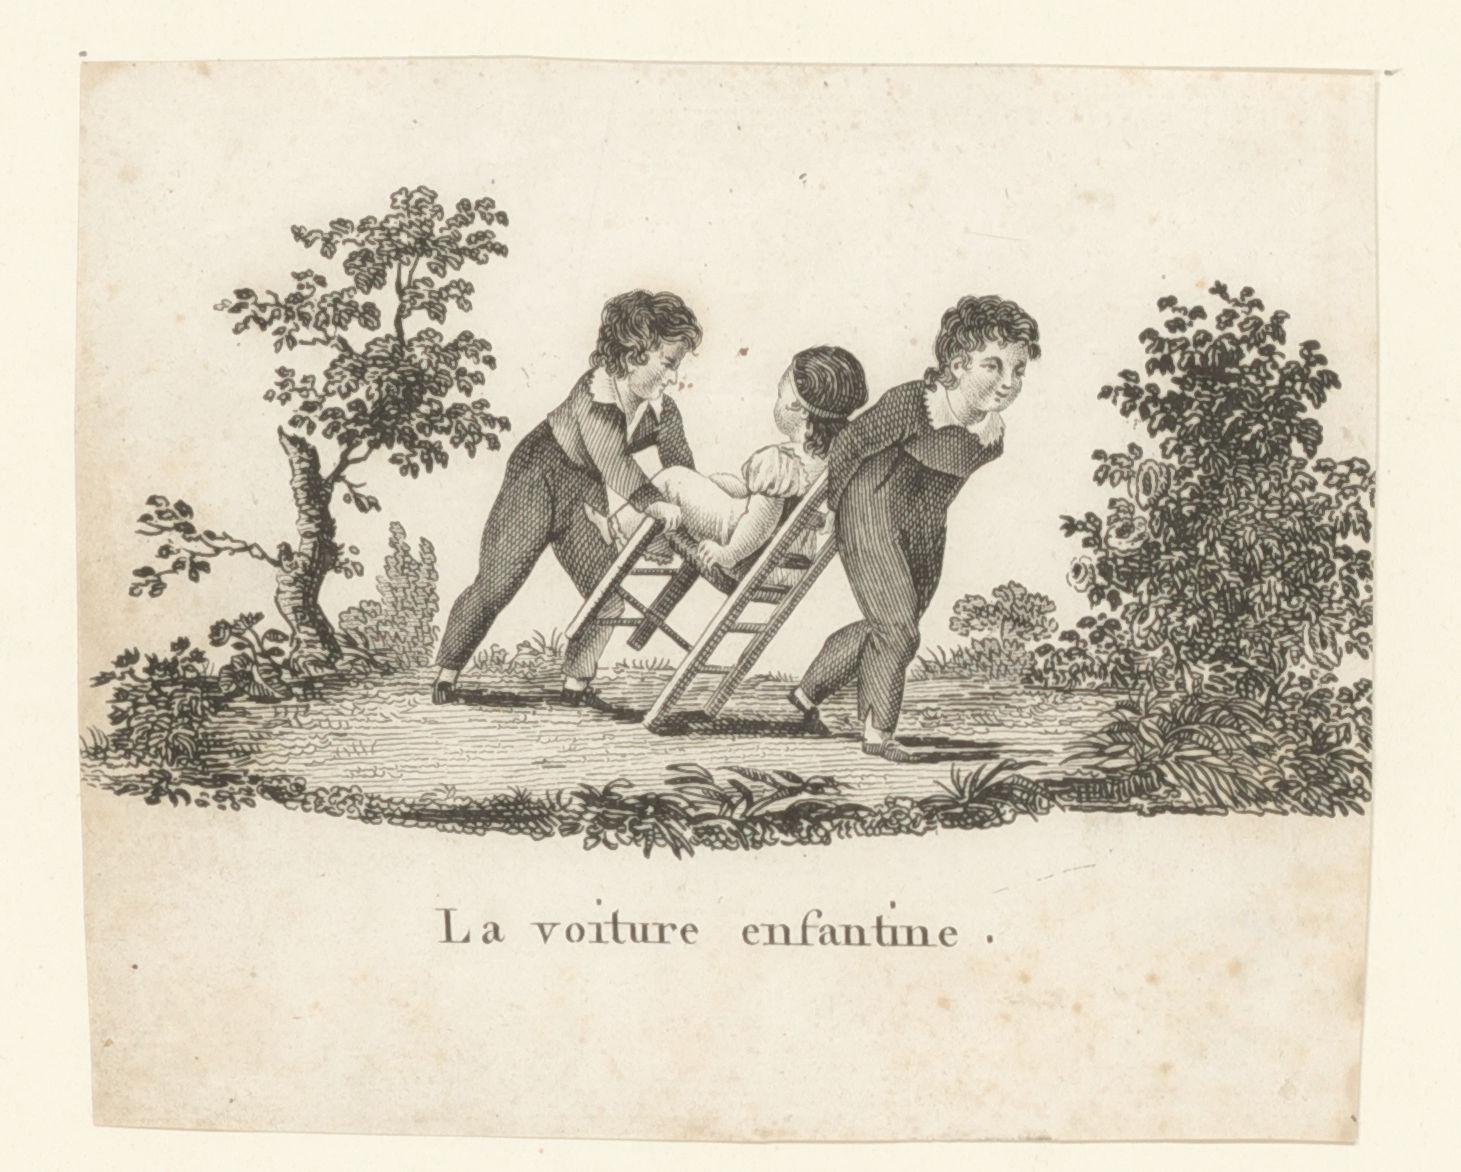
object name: print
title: Twee jongens dragen een meisje op een stoel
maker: Anonymous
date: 1800-1899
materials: paper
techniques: etching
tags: children's games and plays, chair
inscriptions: collector's mark: Lugt 1641, stamp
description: Onderwerpsrubrieken binnen de Atlas Zeden en Gewoonten: Zeden en Gewoonten in Engeren Zin, Des menschen beging, midden en einde, Kinderleven – Kinderspel en Kinderprenten.